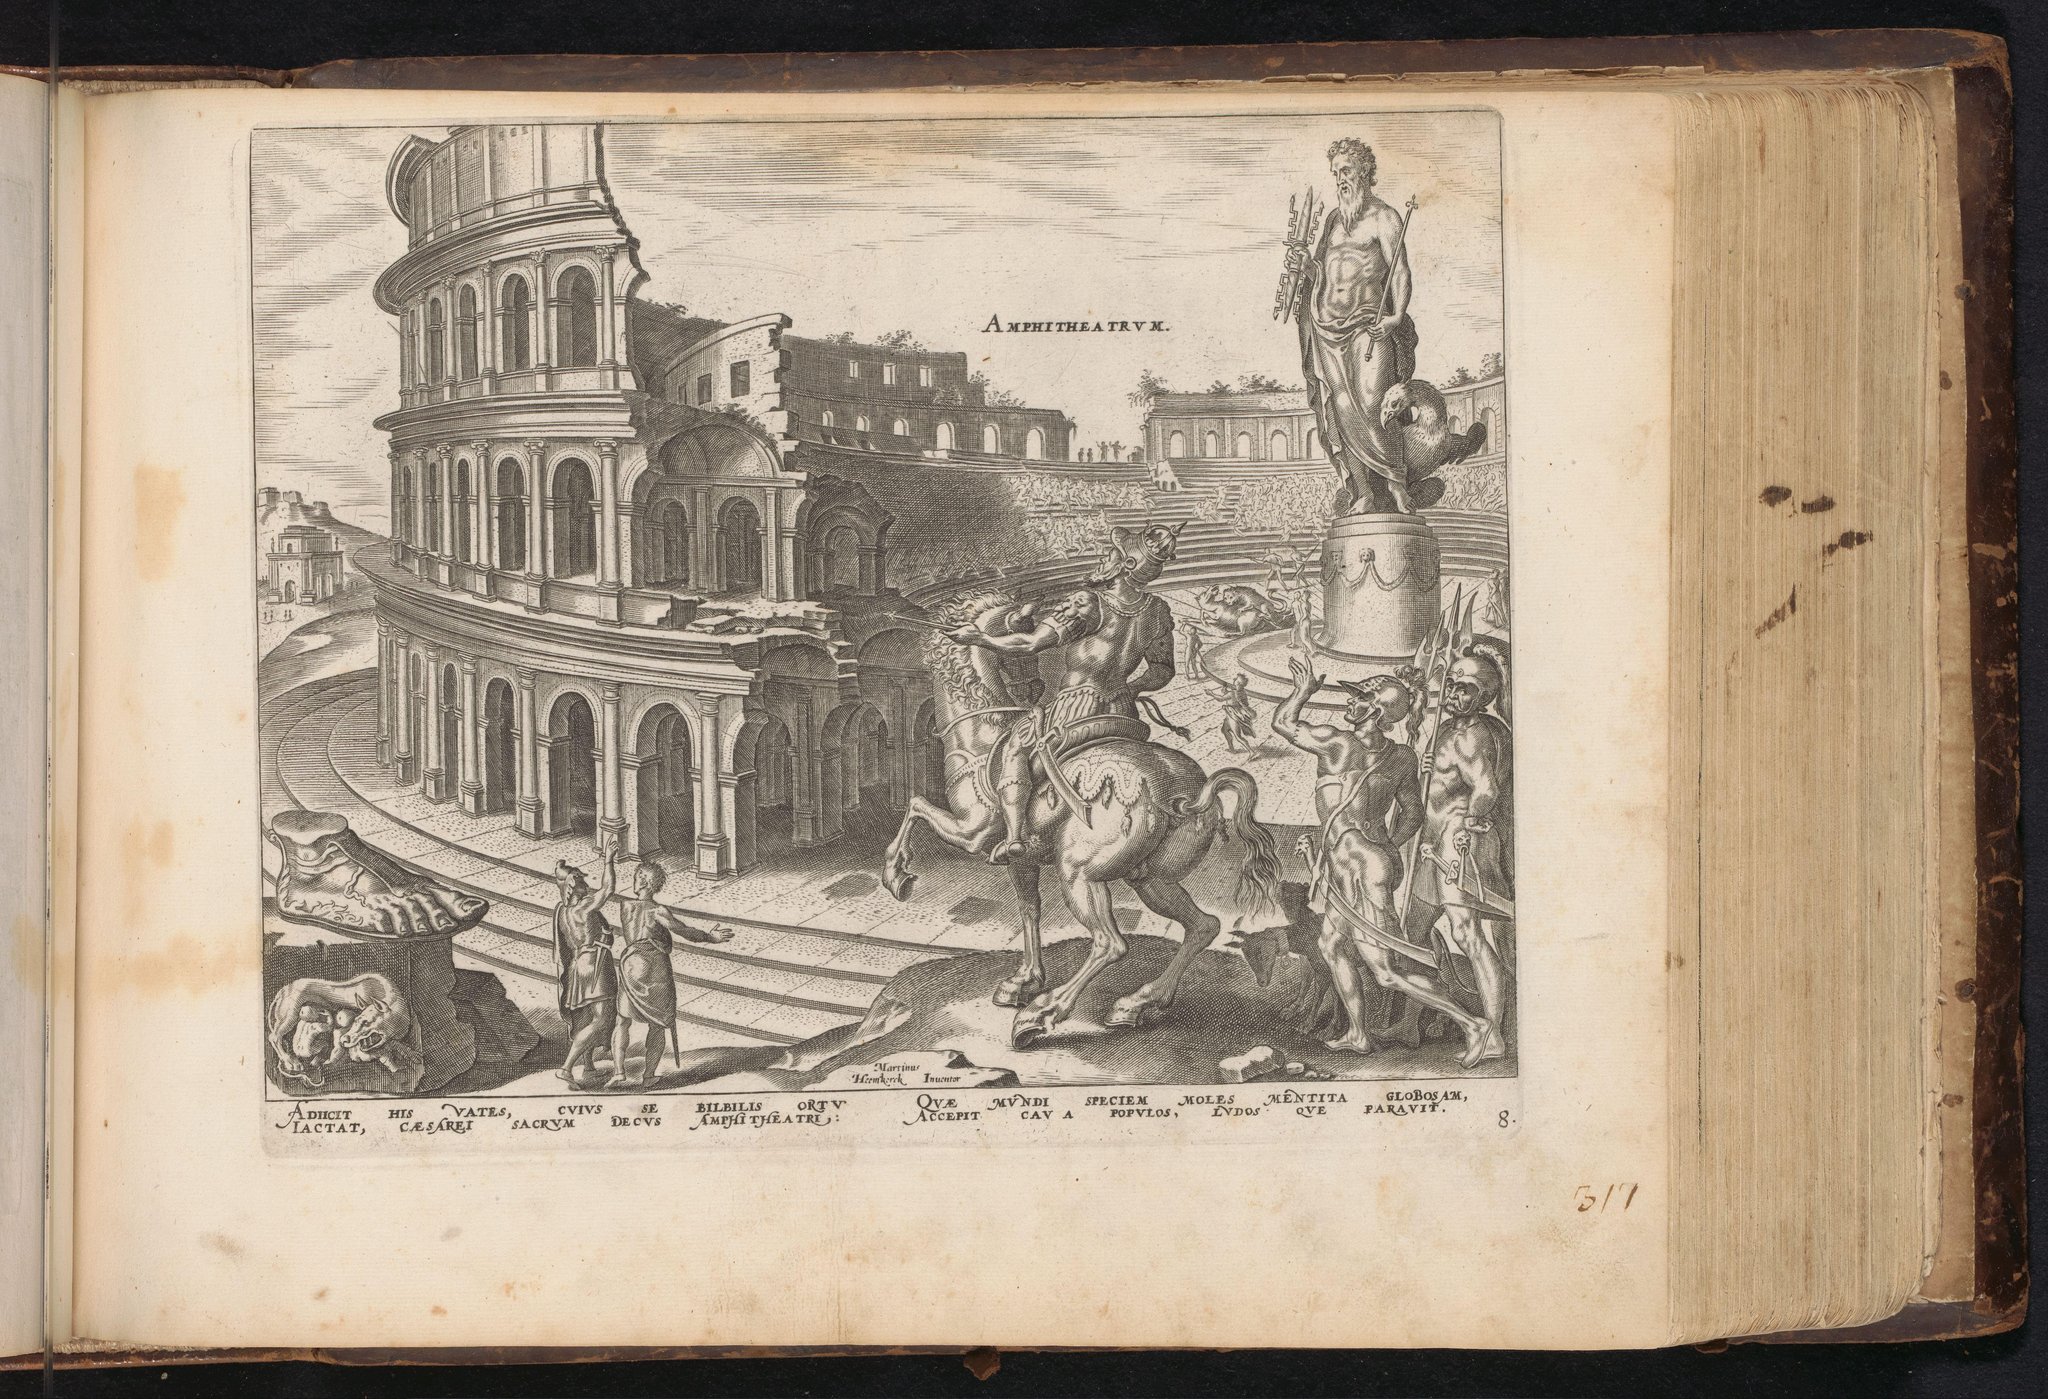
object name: print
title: De acht wereldwonderen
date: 1572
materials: paper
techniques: engraving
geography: alkmaar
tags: vespasian builds the colosseum, other monuments which are sometimes included in the wonders of the world (colosseum)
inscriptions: number: ‘317’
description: De ruïne van het Romeins Colosseum. Centraal in het Colosseum een standbeeld van Jupiter. Er zijn gevechten aan de gang. In de voorgrond keizer Vespasianus te paard. Hij had opdracht gegeven tot de bouw van het Colosseum. Links in de voorgrond een reliëf met Romulus en Remus, die gezoogd worden door een wolf. Onder de voorstelling een vers in het Latijn. Deze prent maakt deel uit van een album.